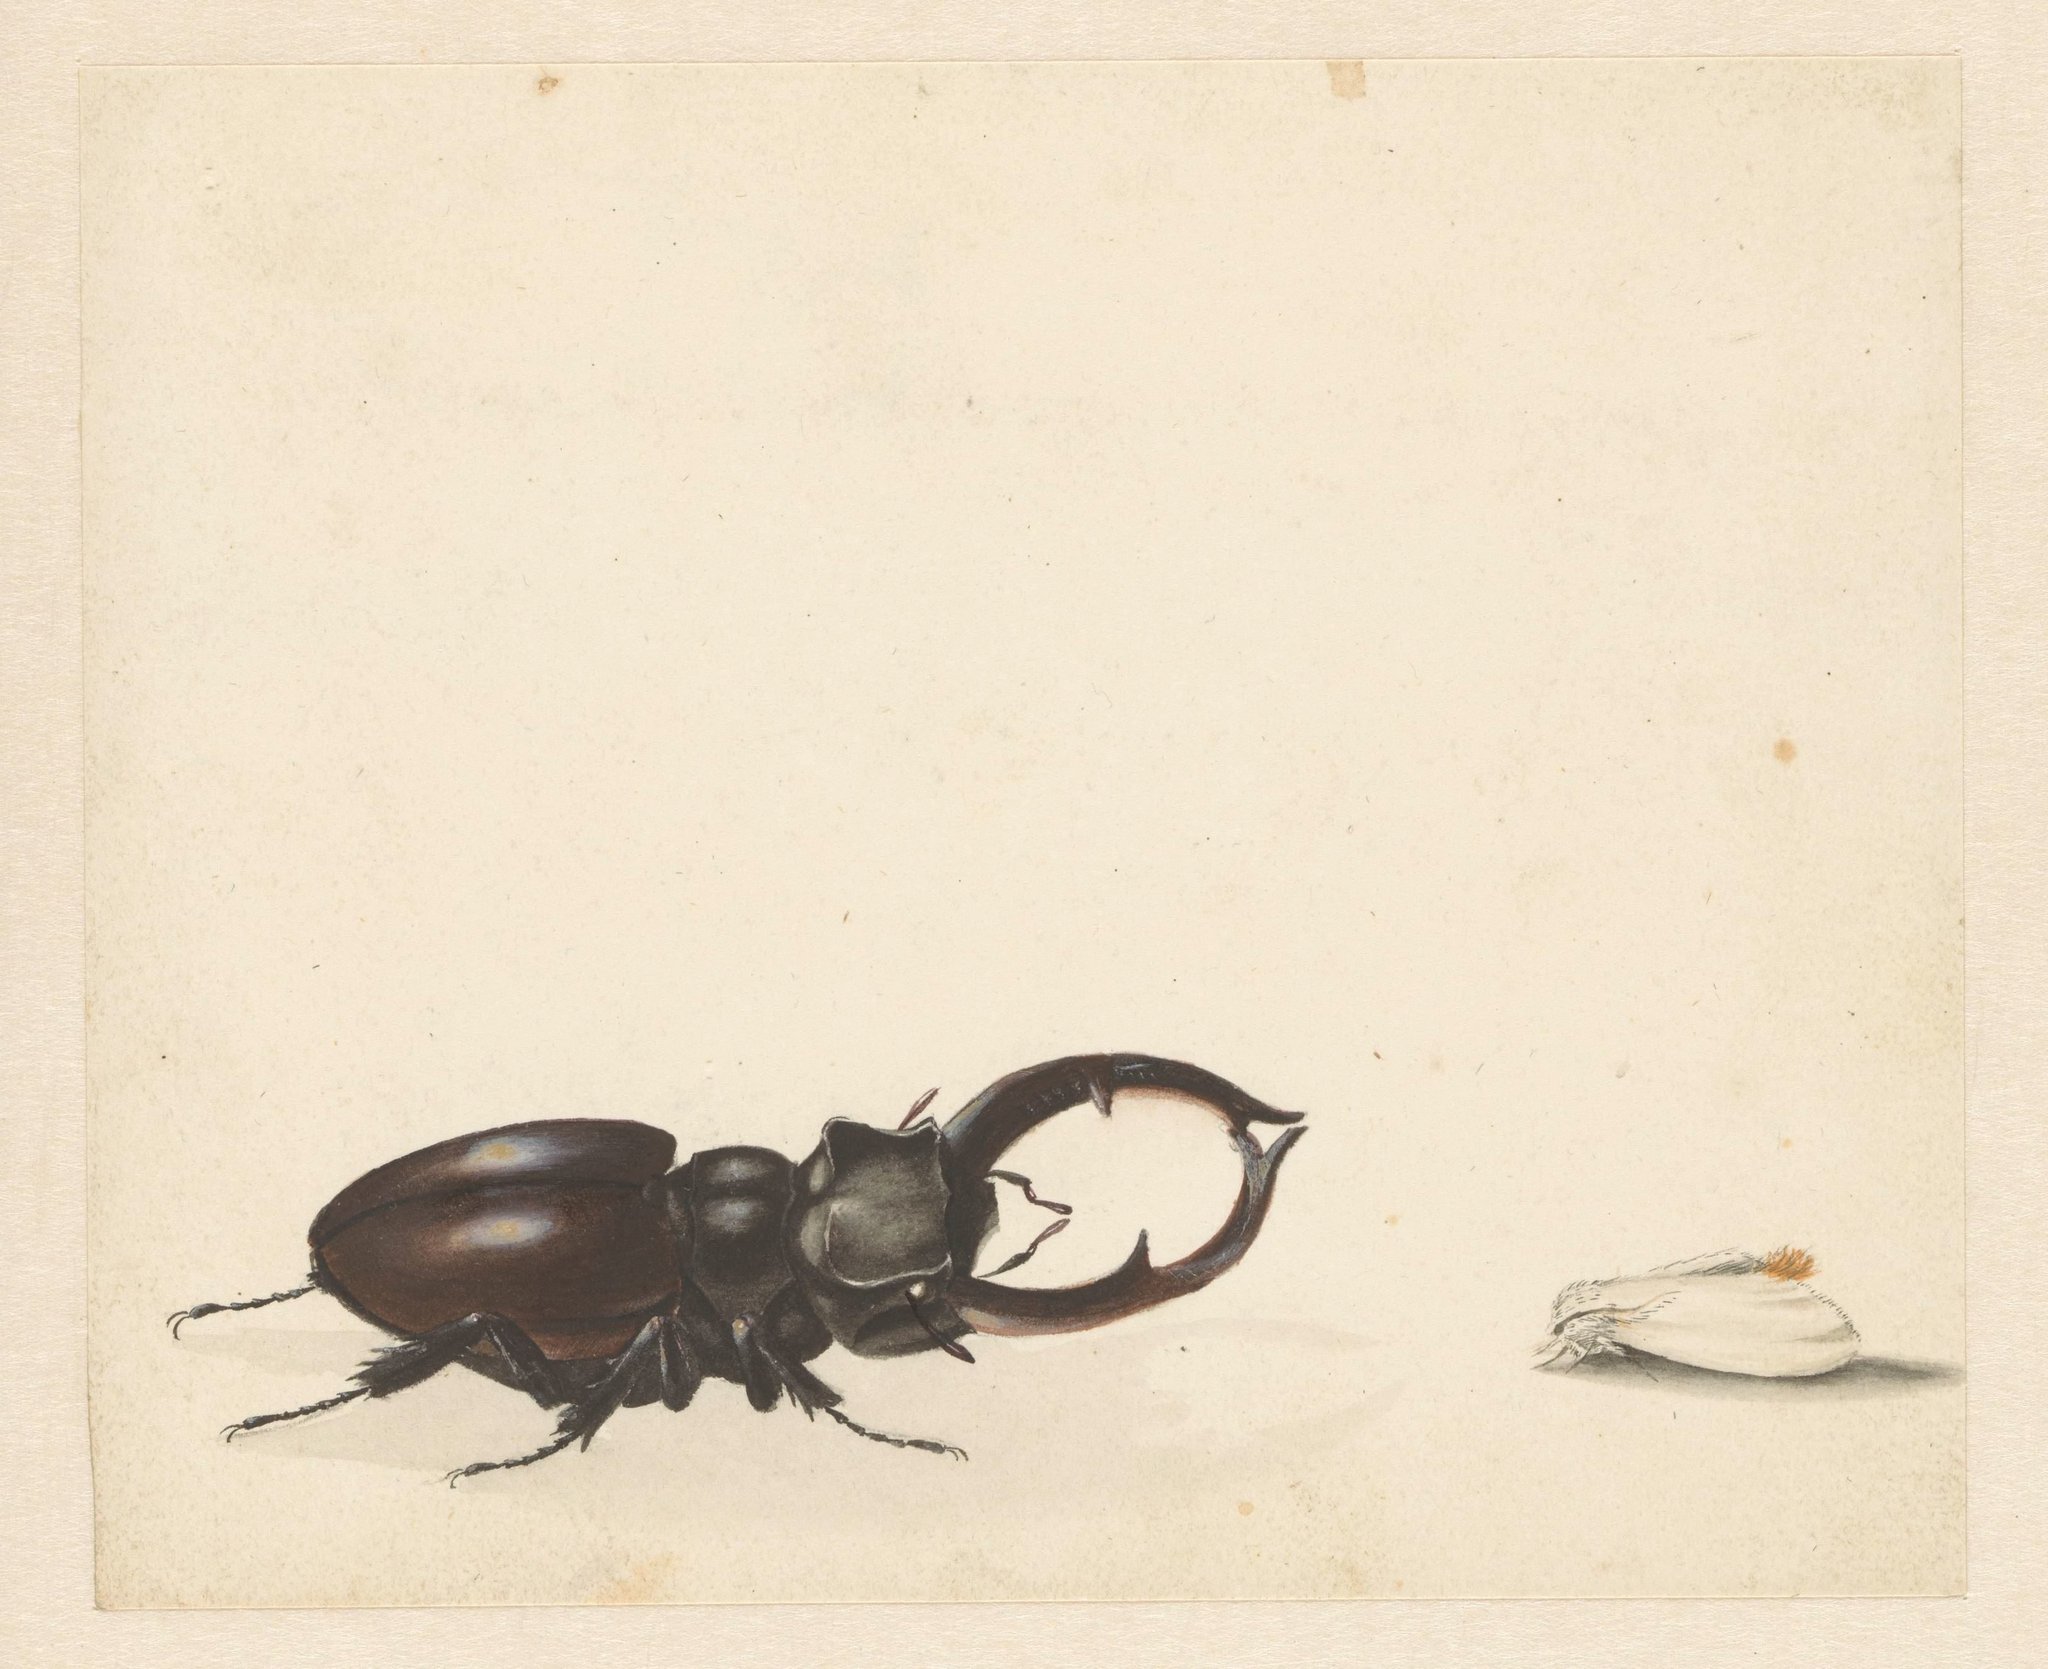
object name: watercolor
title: Studieblad met vliegend hert en pas uitgekomen nachtvlinder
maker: albertus steenbergen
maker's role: draughtsman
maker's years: 1814-1900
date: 1824-1900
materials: paper, pencil, watercolor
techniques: brush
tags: insects: moth